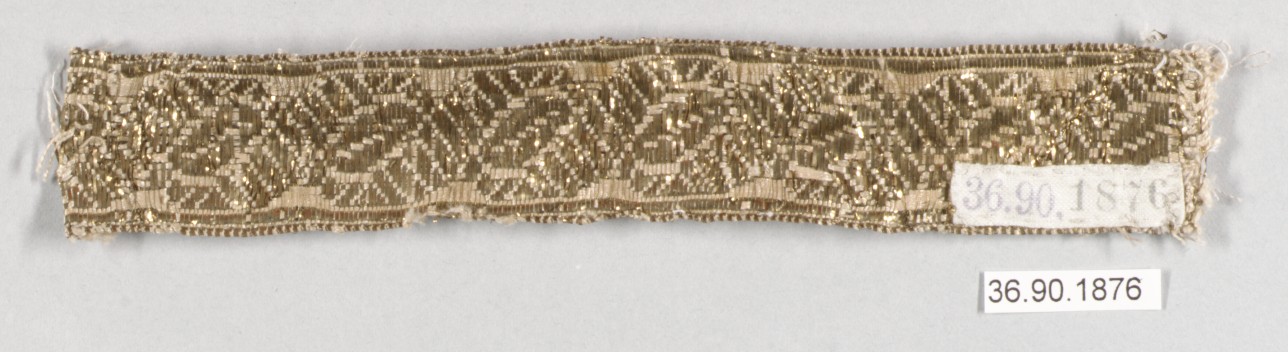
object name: galloon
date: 1801-1900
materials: silk